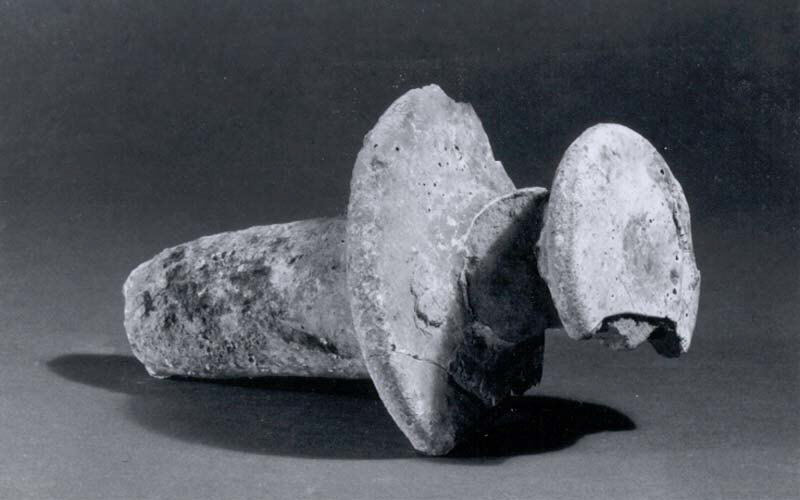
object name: wall nail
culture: iranian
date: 900-801 BCE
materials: ceramic, glaze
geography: iran